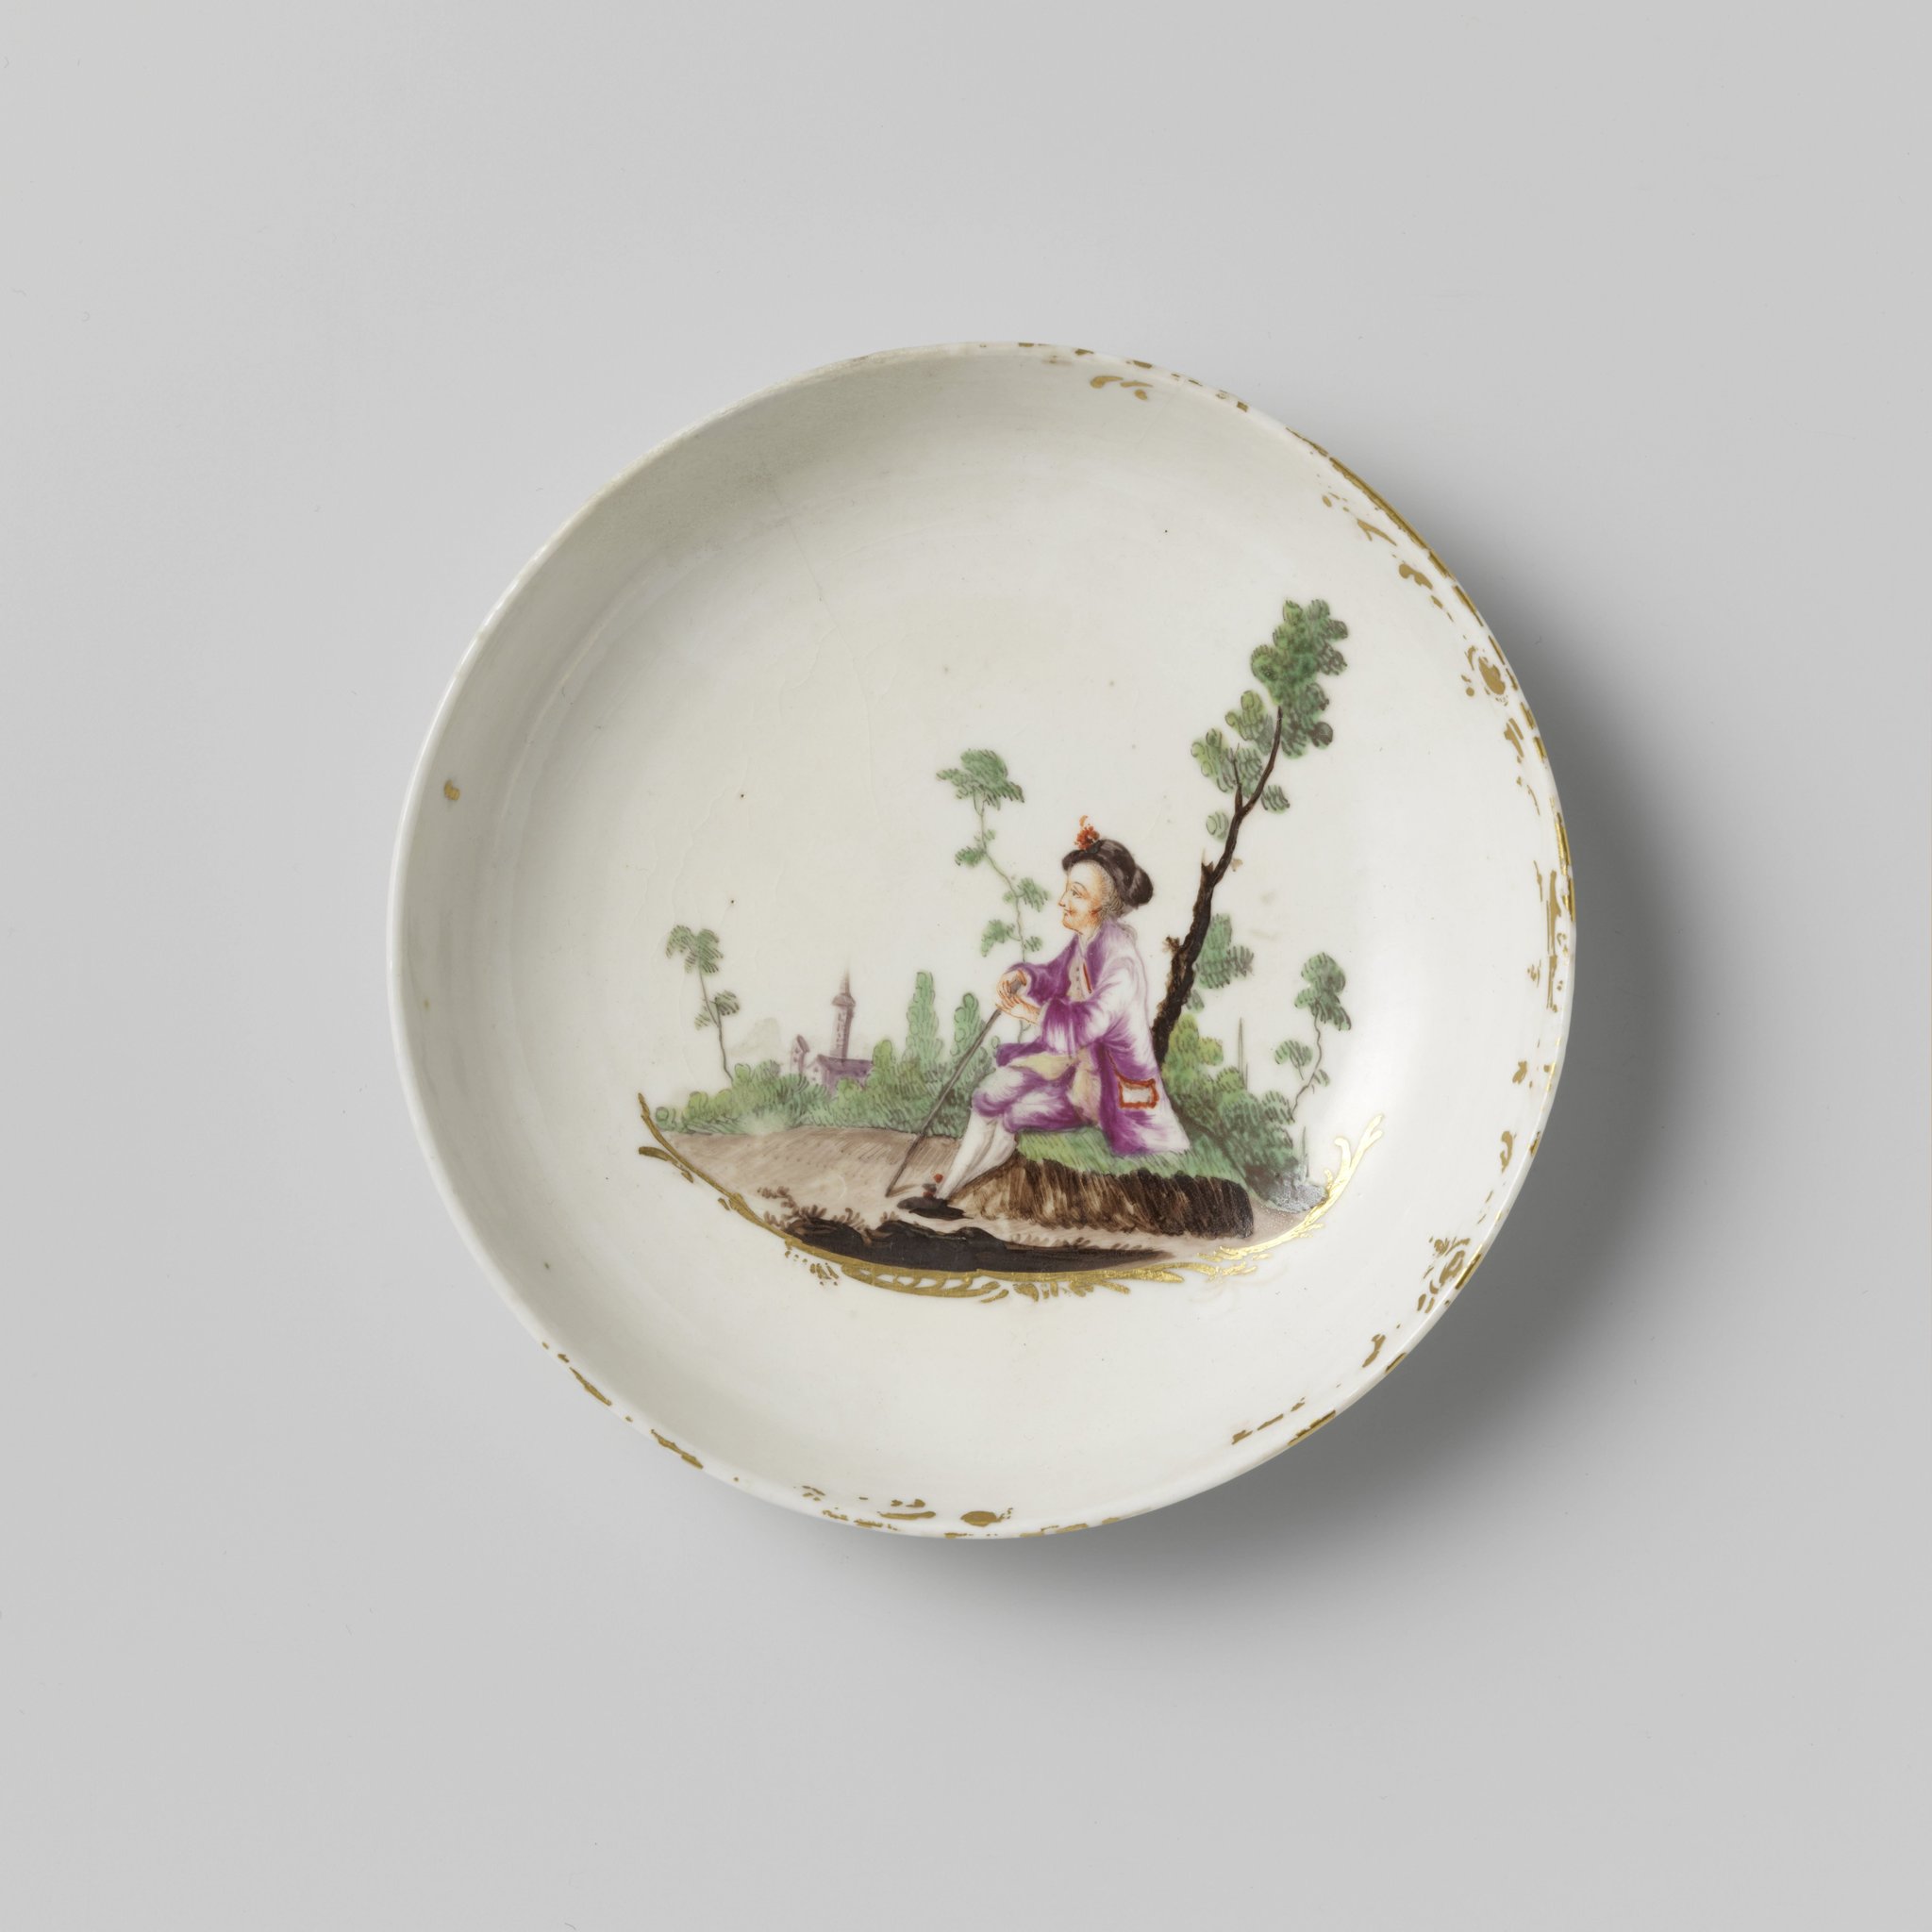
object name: platter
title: Schotel veelkleurig beschilderd met een man in een landschap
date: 1759-1771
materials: porcelain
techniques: painted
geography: weesp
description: Schotel met een veelkleurige versiering van een man in een landschap. Gemerkt met twee gekruiste zwaarden en drie bollen in onderglazuurblauw.